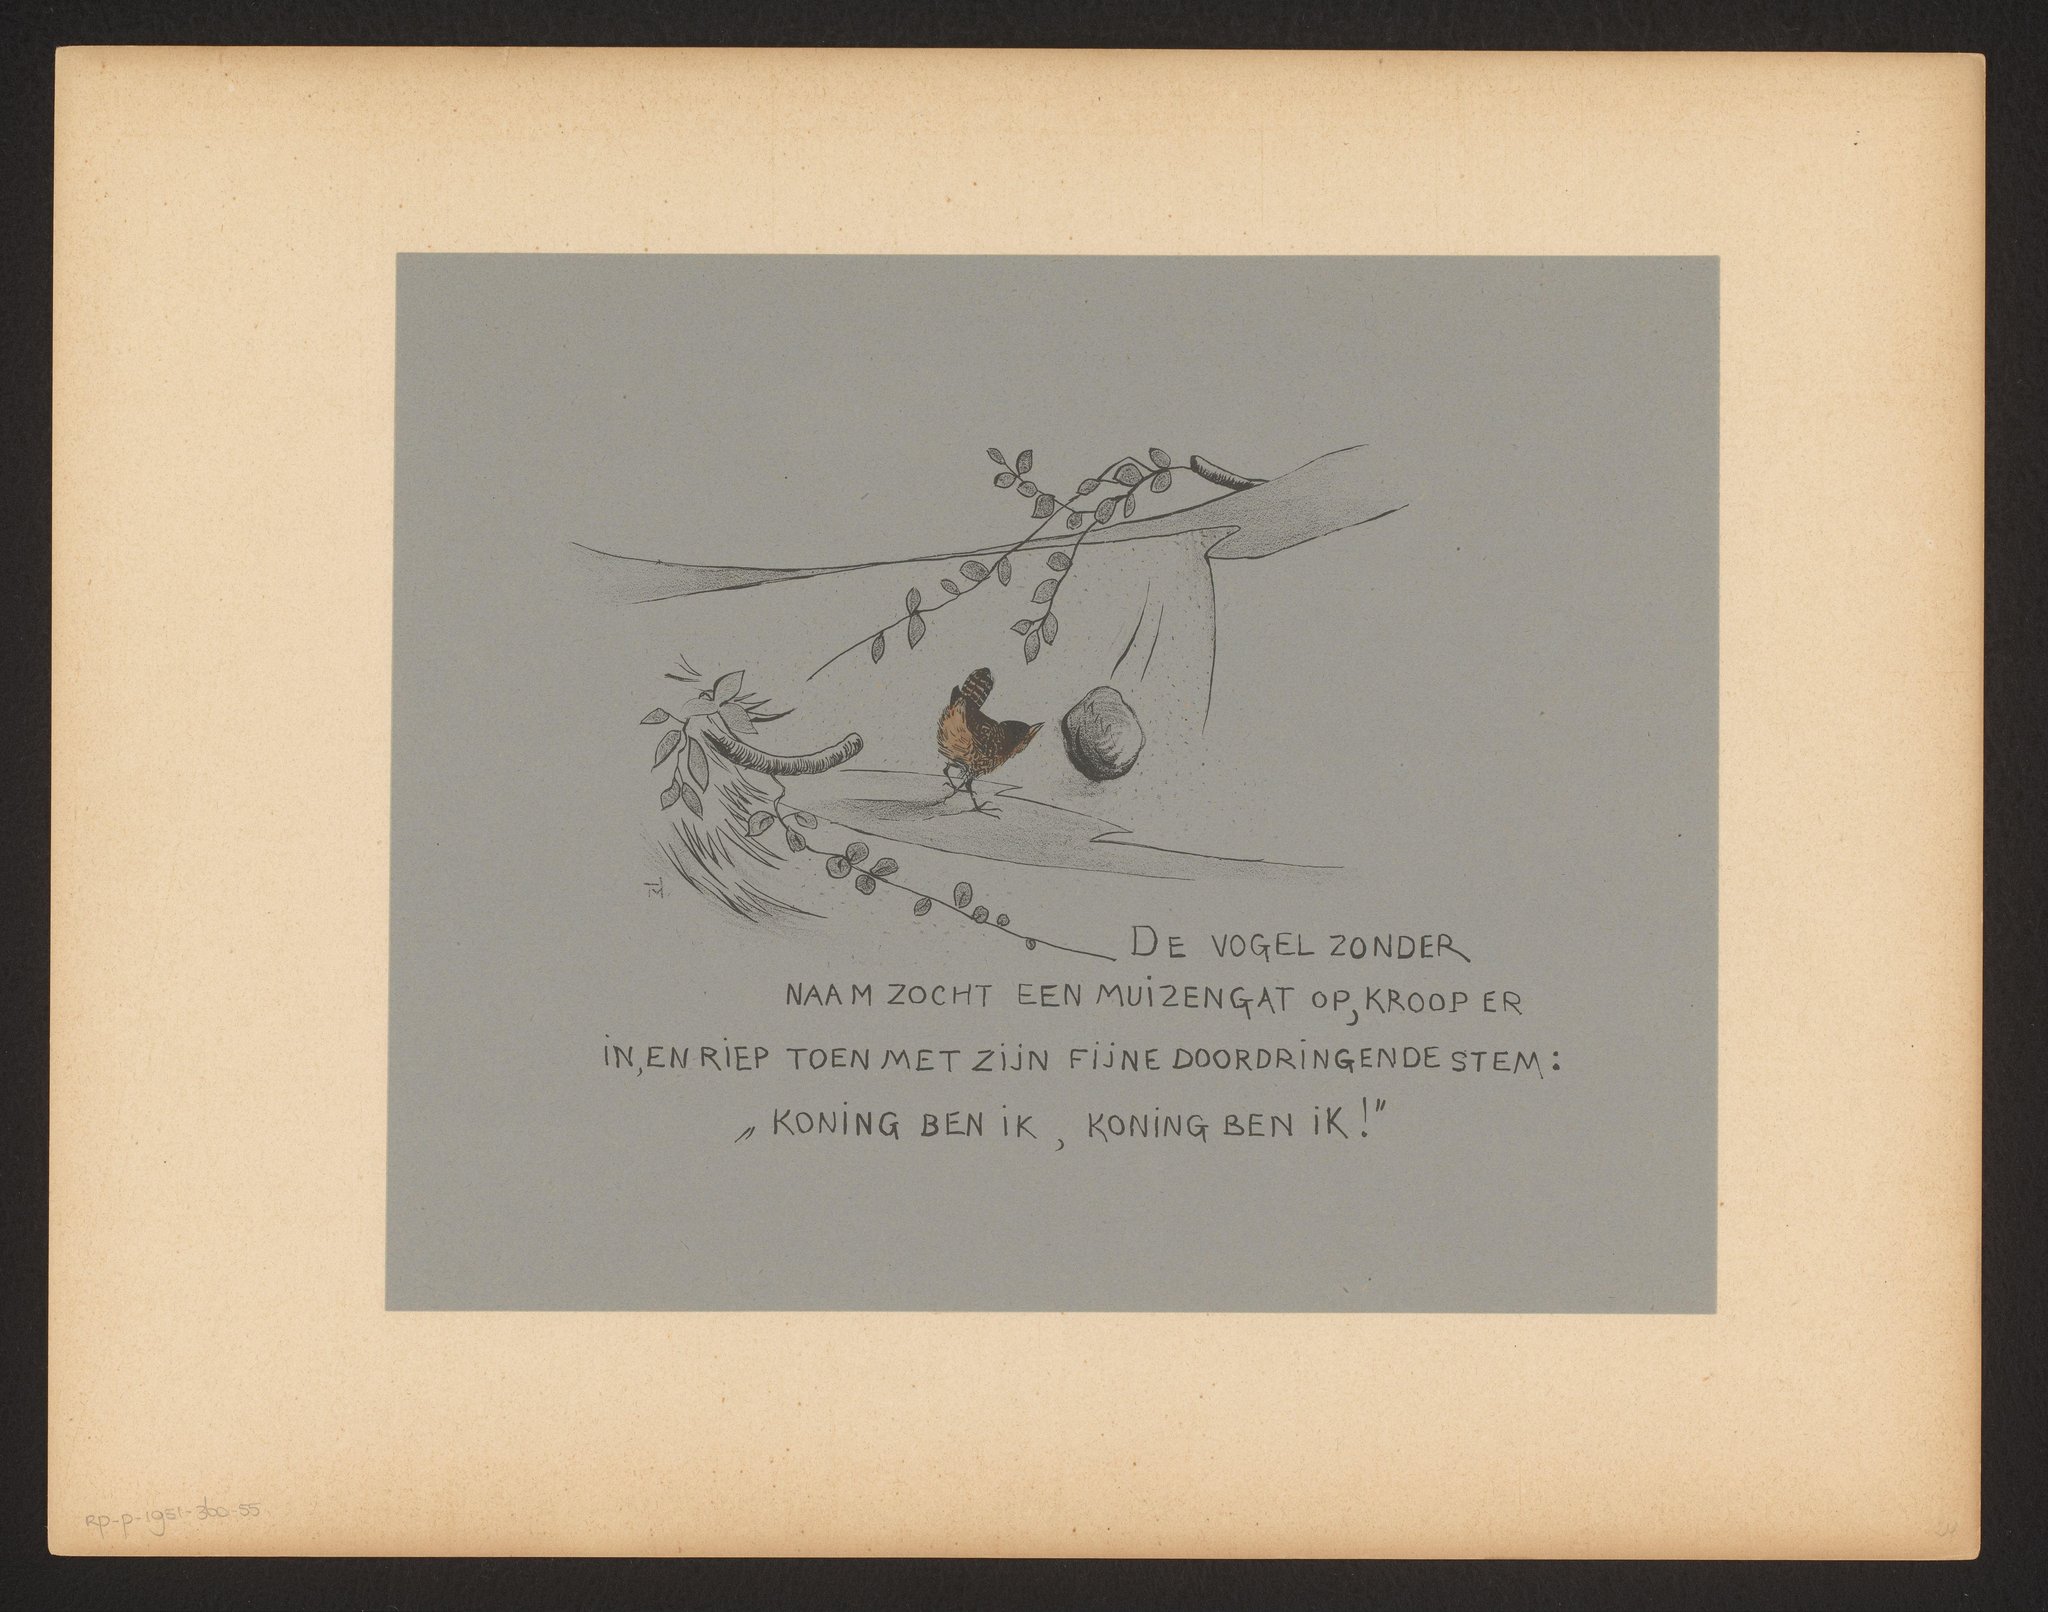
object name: print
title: Hoe de vogels aan een koning kwamen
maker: theo van hoytema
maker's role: draughtsman, painter, print maker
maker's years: 1863-1917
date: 1892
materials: paper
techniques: hand coloring, lithograph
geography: the hague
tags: song-birds: wren, pit, hole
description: Zowel tekst als afbeelding zijn gelithografeerd.